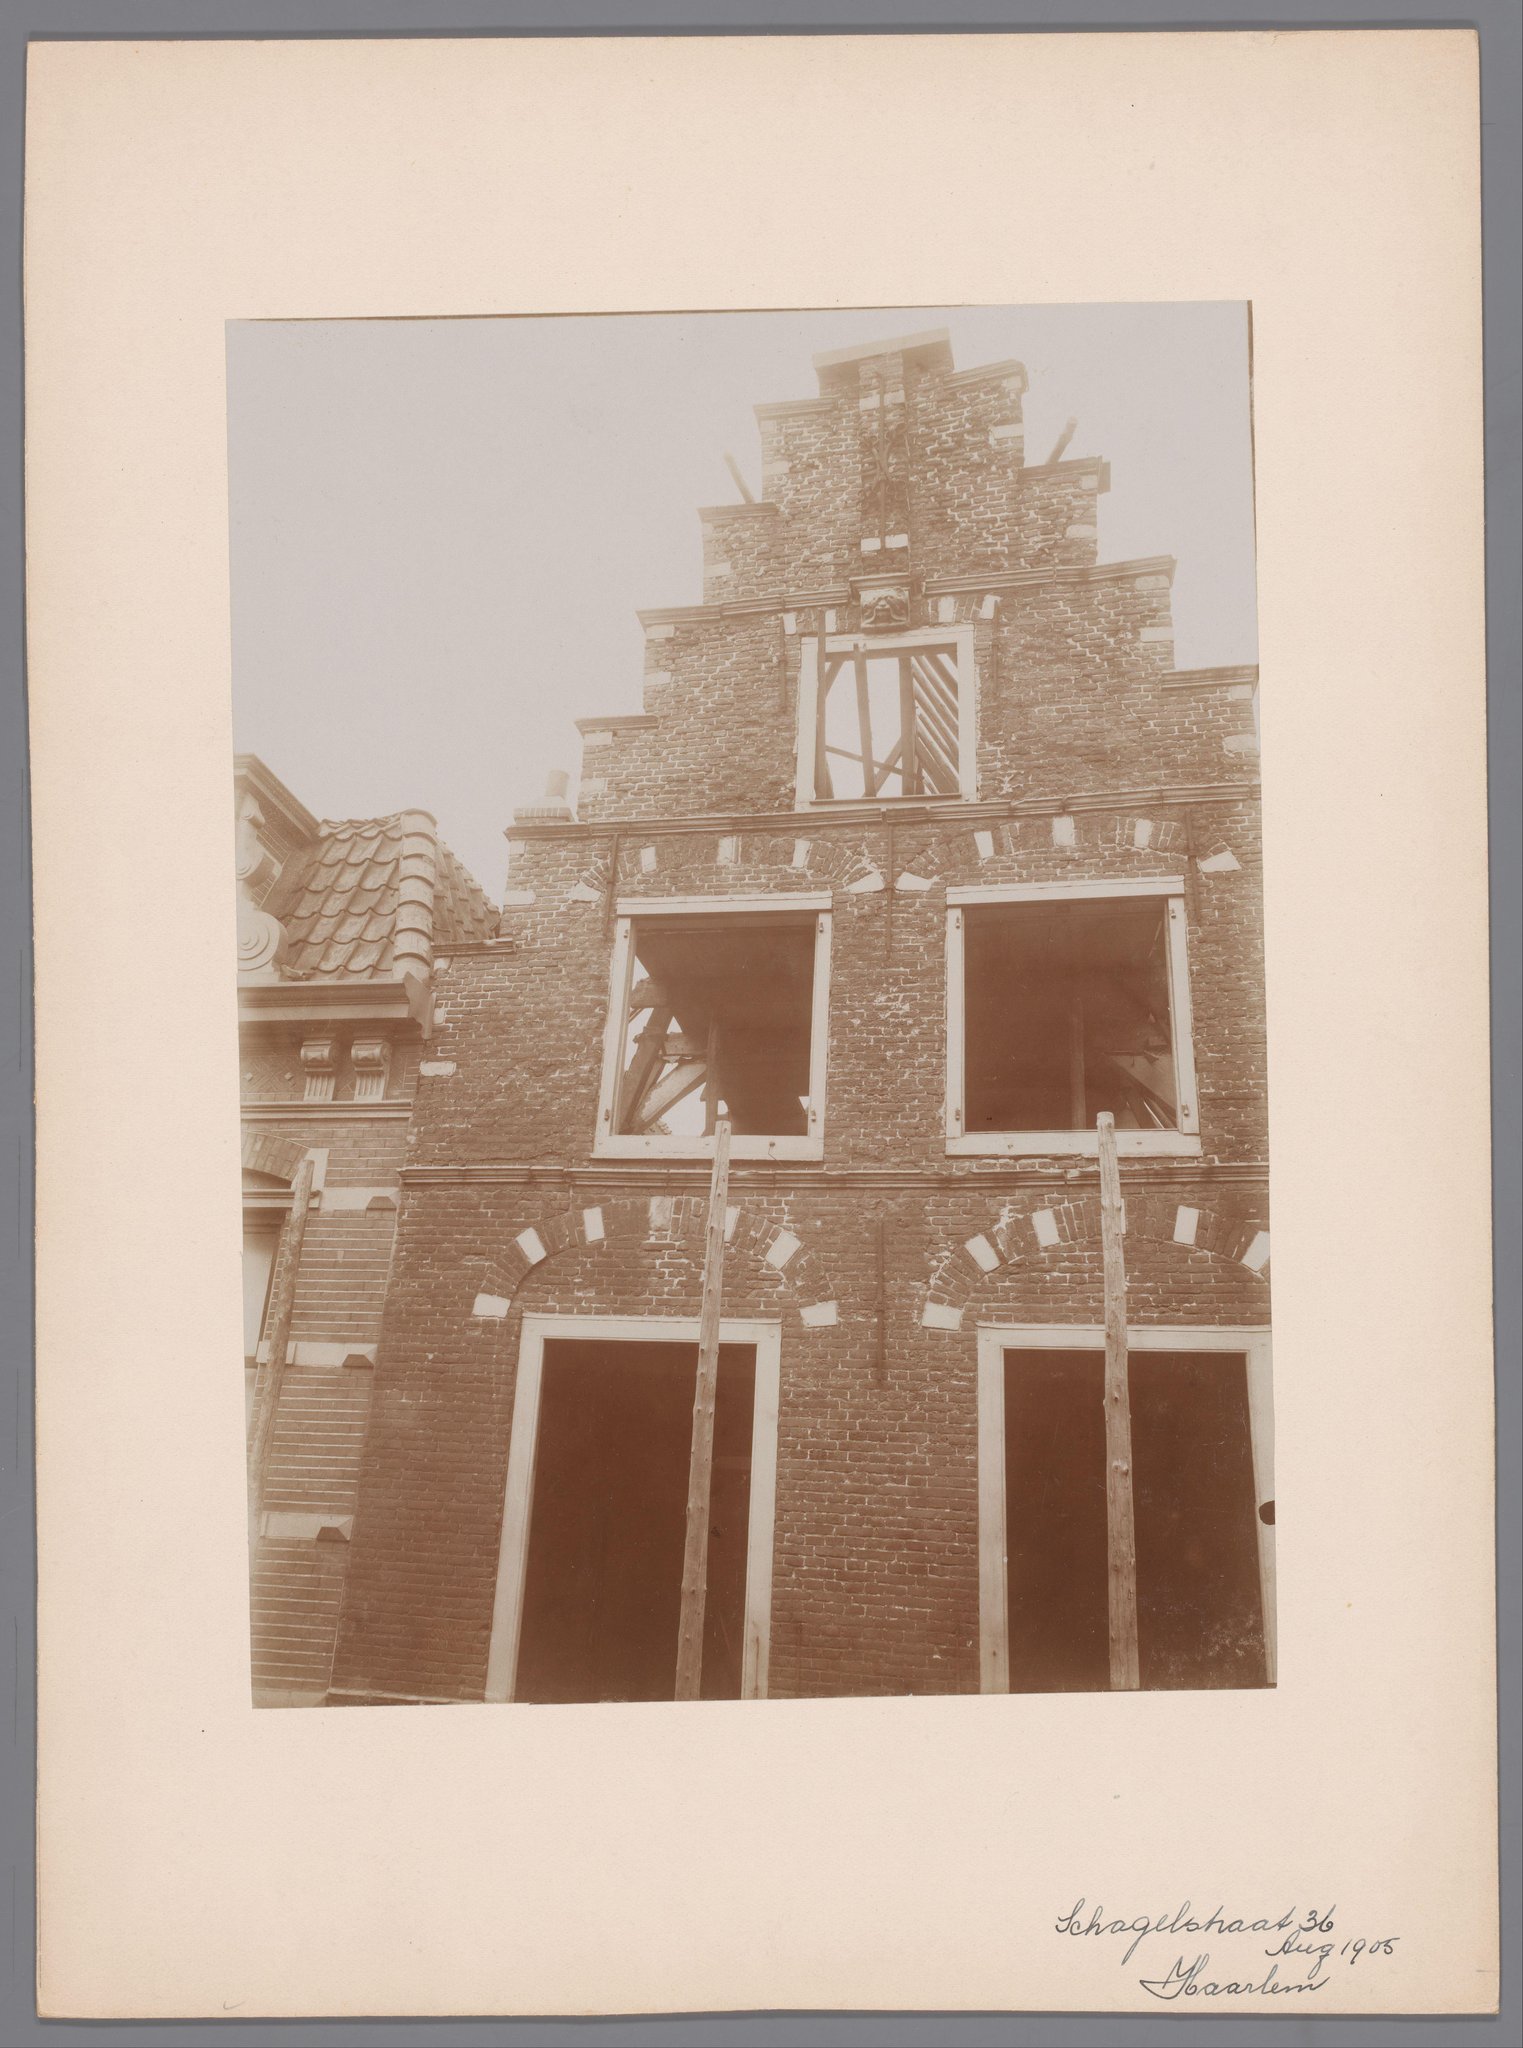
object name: photograph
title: Façade van Schagelstraat 36 te Haarlem tijdens de restauratie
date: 1905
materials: cardboard, photographic support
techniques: collodion silver print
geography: schagelstraat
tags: urban housing, façade (of house or building)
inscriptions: annotation: ‘Schagelstraat 36/ Aug 1905/ Haarlem’, annotation: ‘Haarlem Schagelstraat 36 (N.H.)/ Aug 1905’